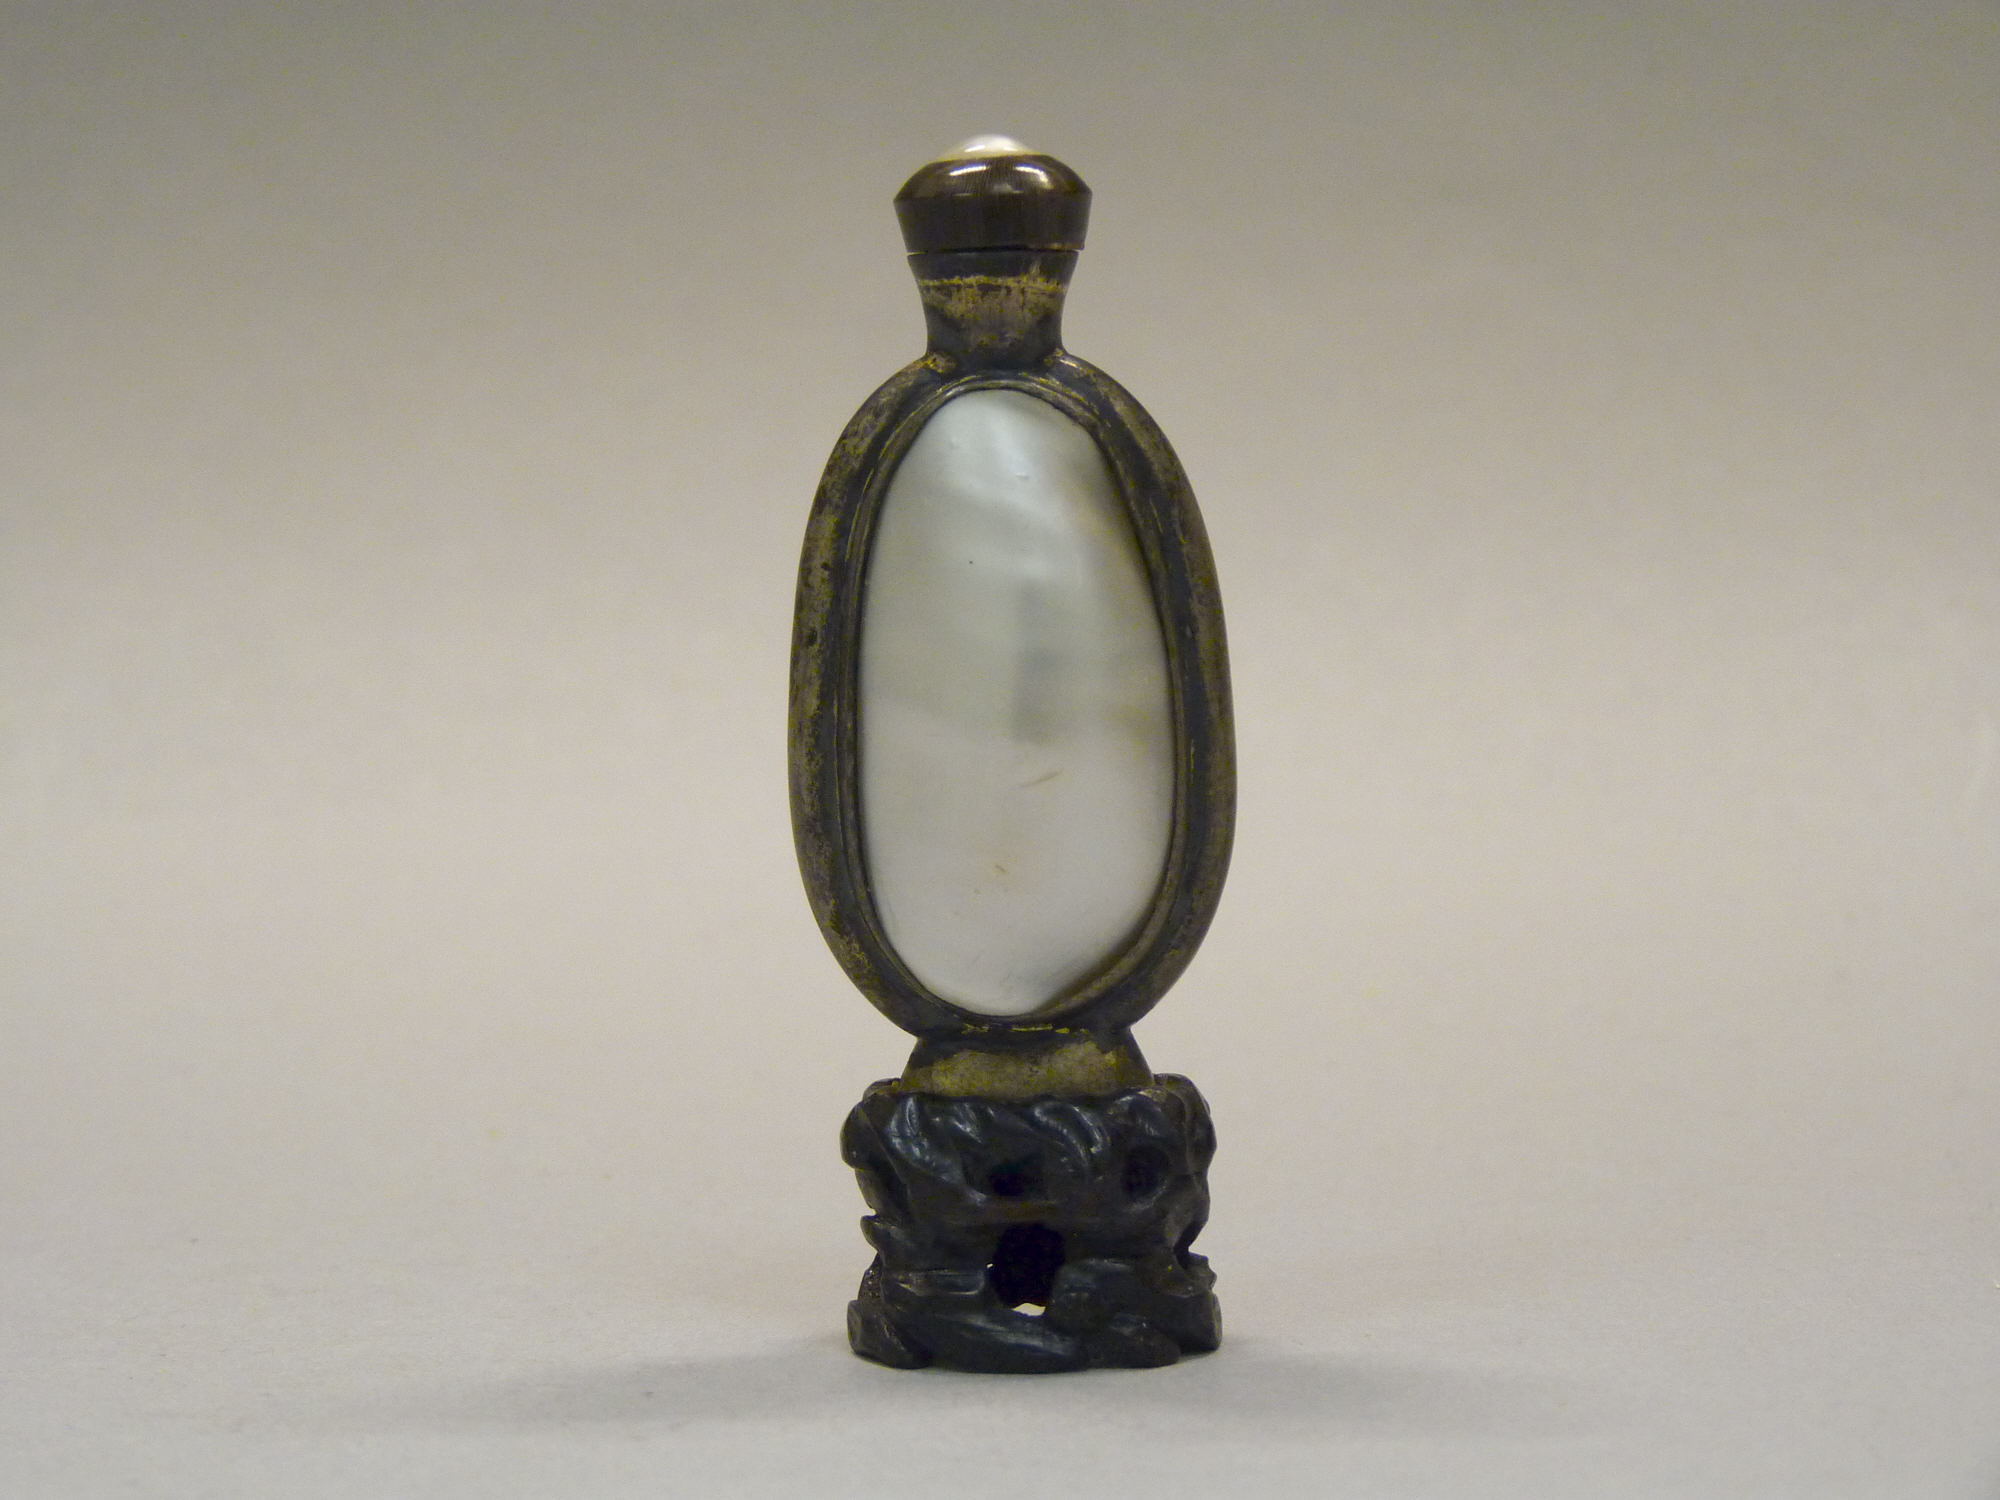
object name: snuff bottle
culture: chinese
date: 1801-1900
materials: mother of pearl, pearl, shell, silver